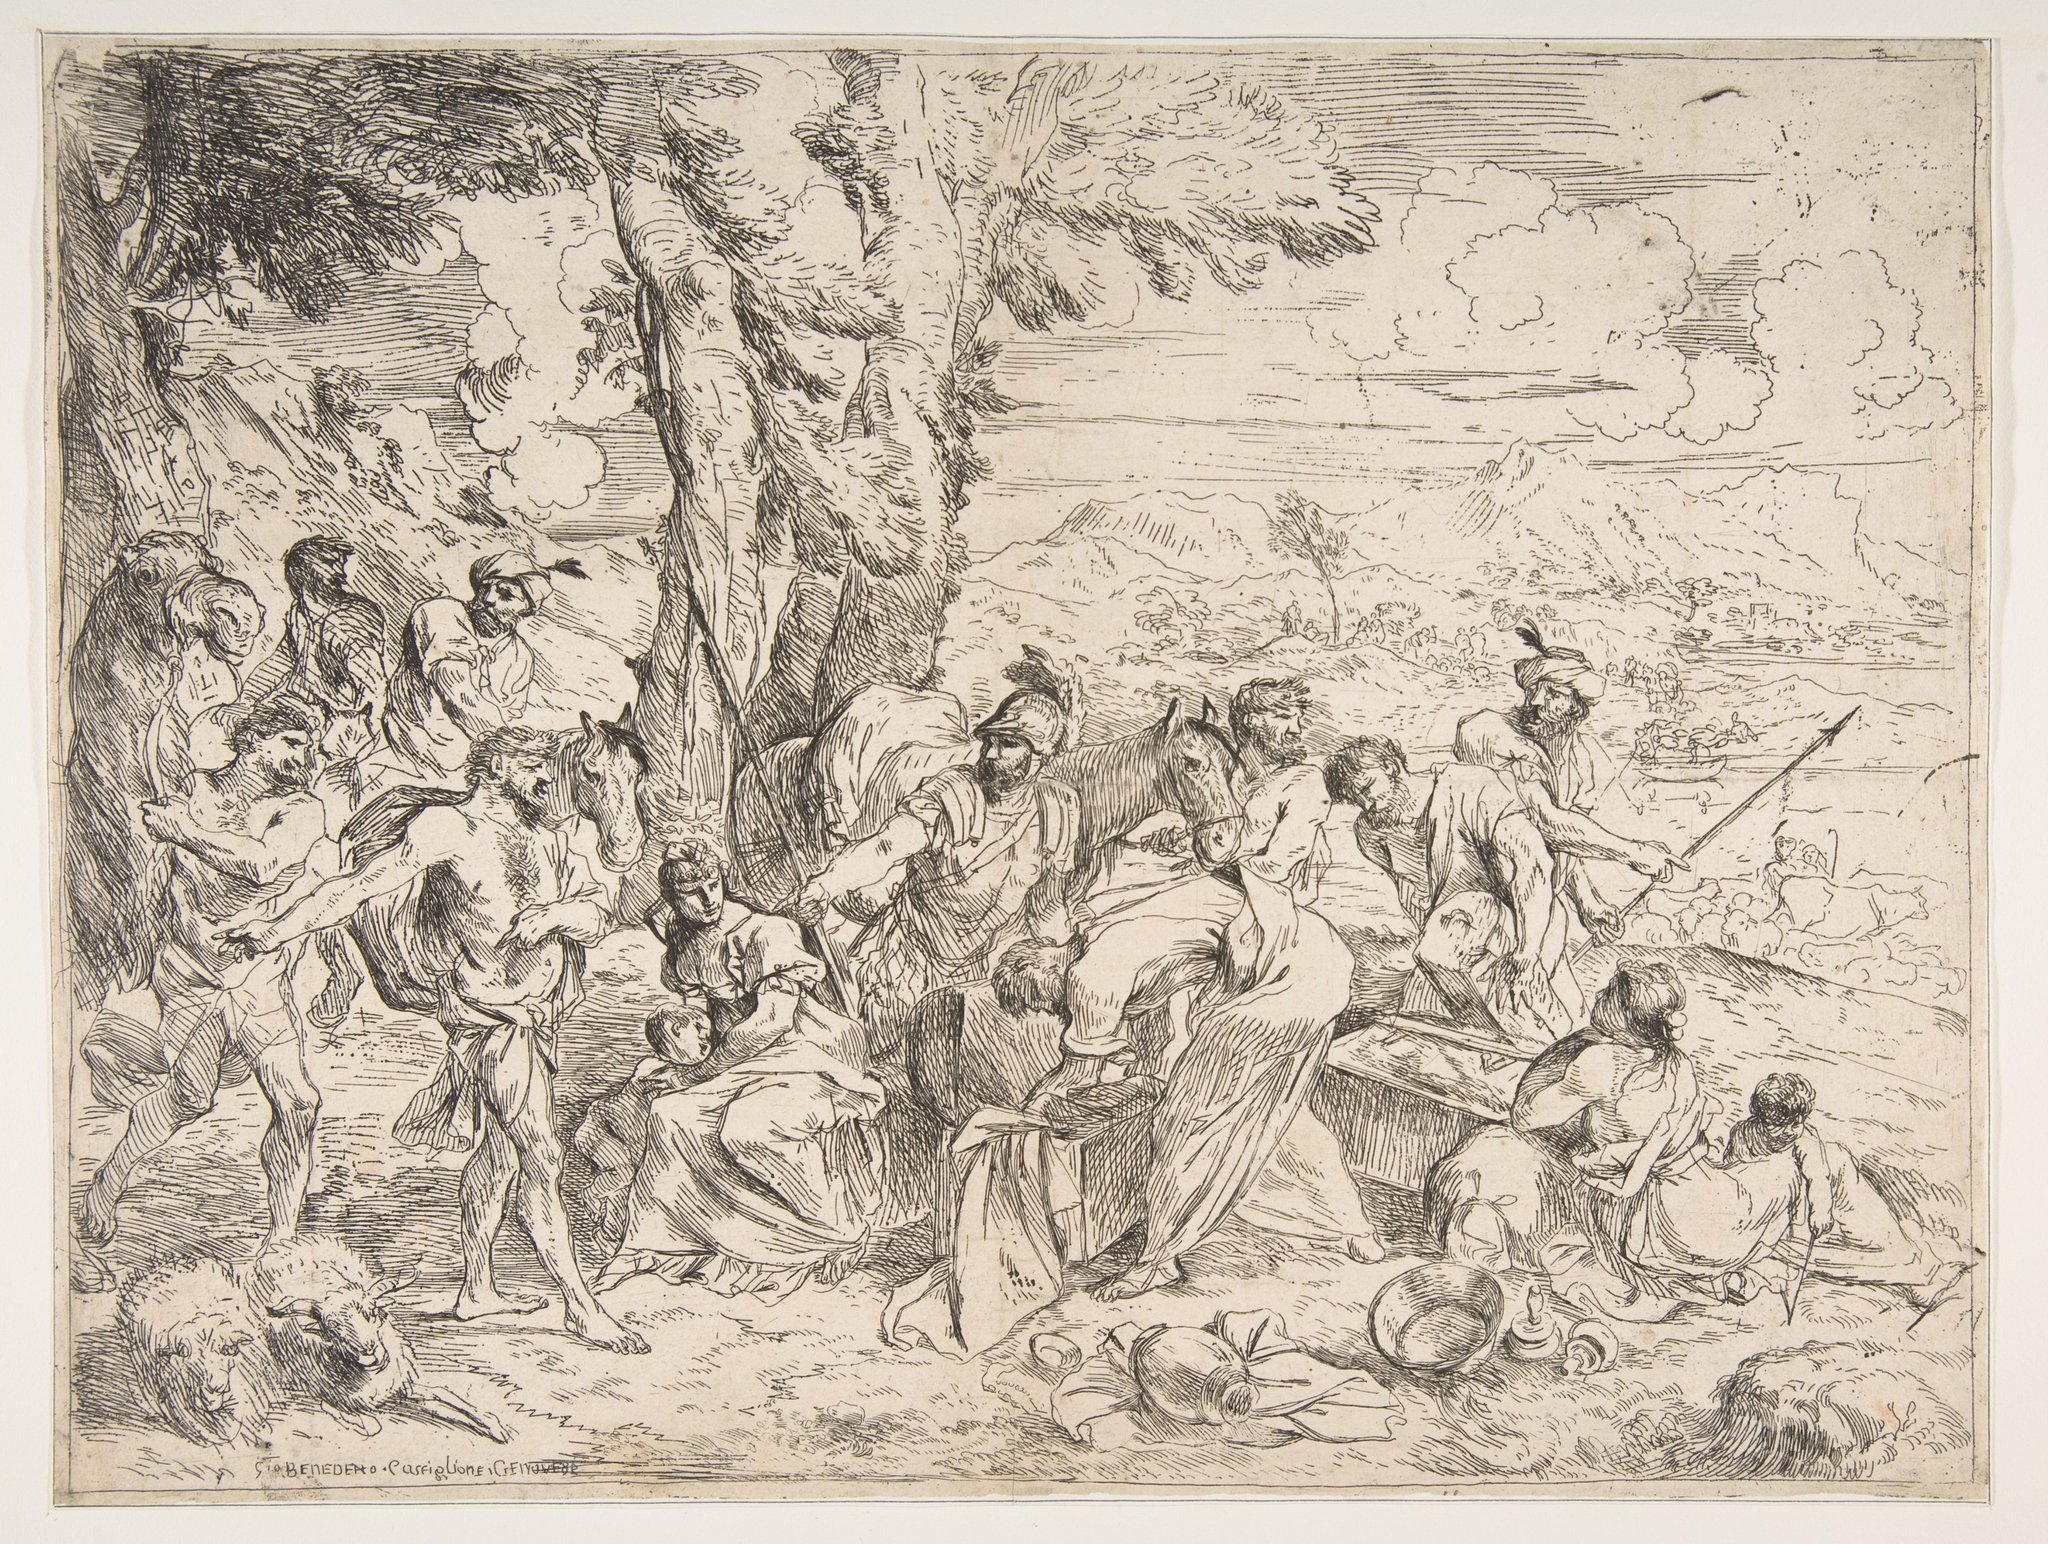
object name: print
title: Laban searching for idols among Jacob's possessions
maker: giovanni benedetto castiglione (il grechetto)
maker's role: artist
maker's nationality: italian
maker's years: 1609-1664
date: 1635-1640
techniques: etching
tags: men,horses